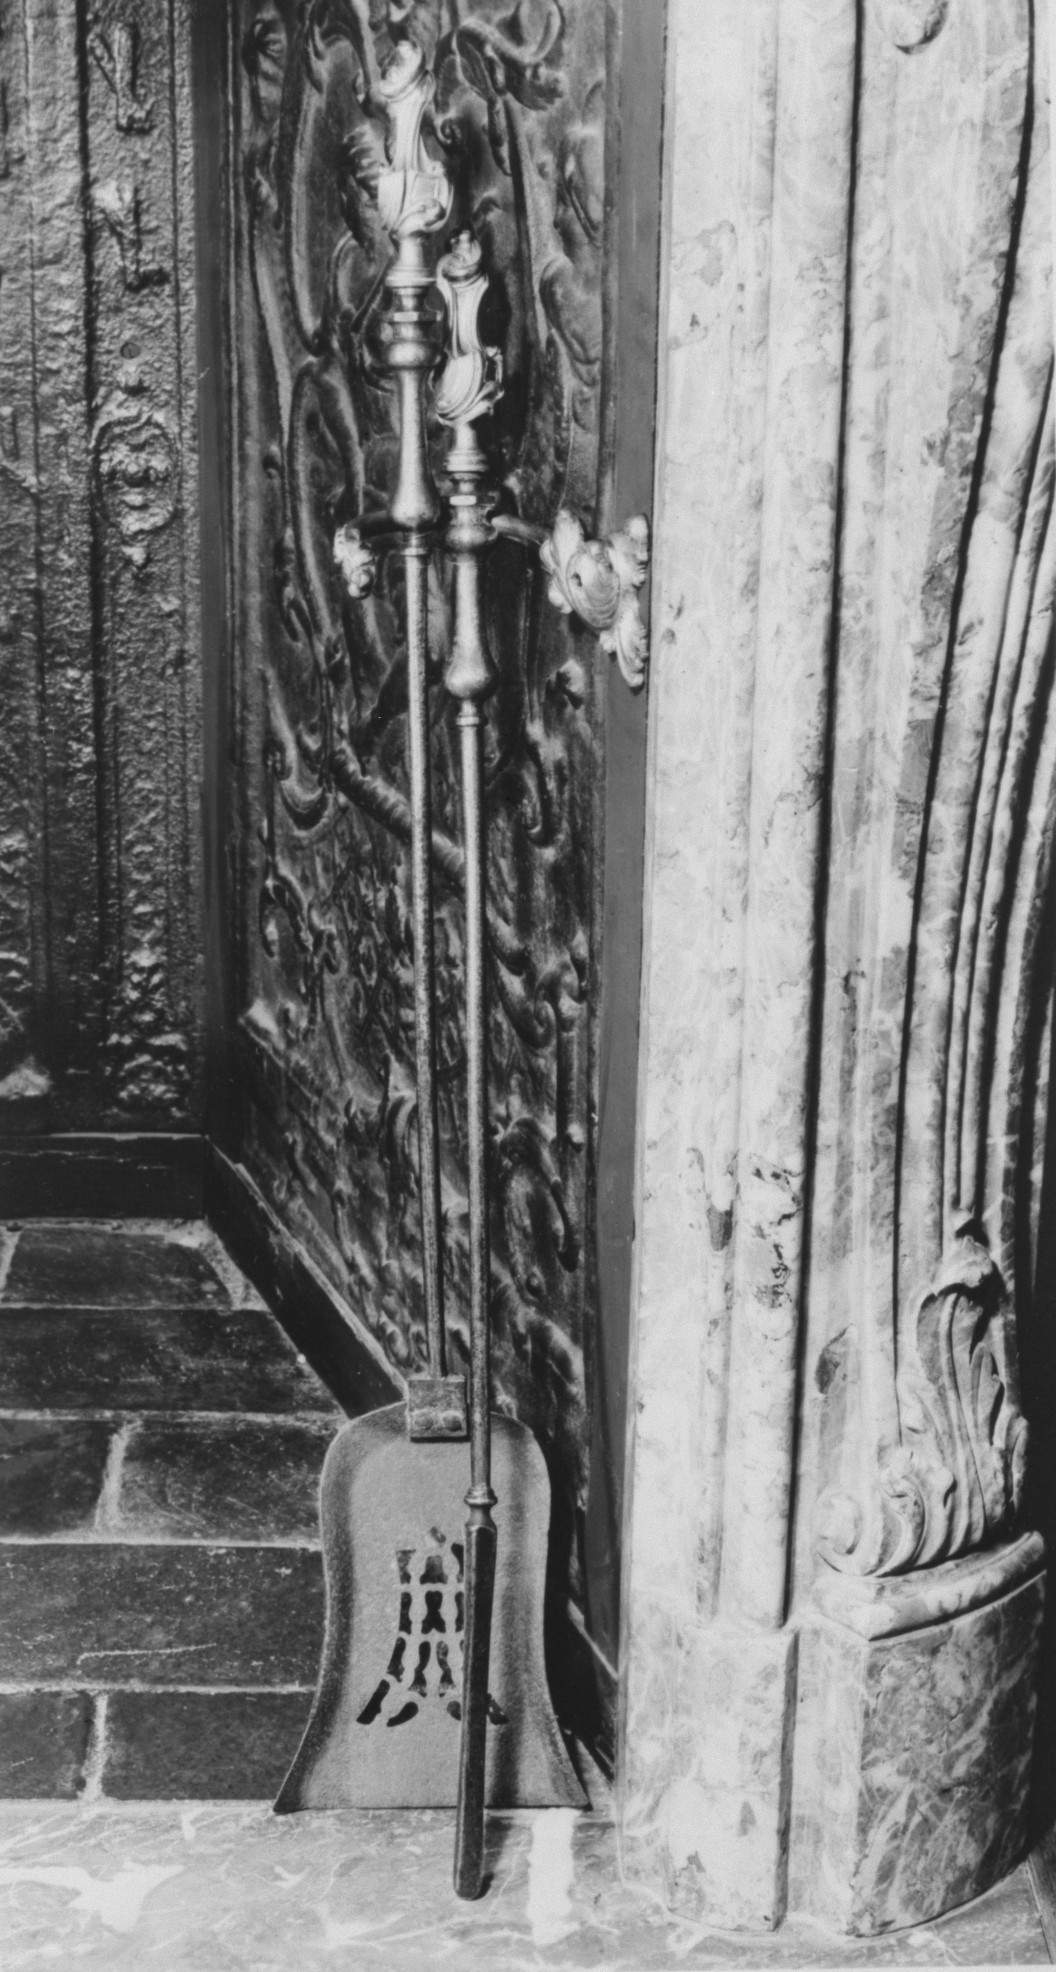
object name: fire iron holder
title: Fire iron holder (one of a pair) (part of a set)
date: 1730-1760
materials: gilt bronze